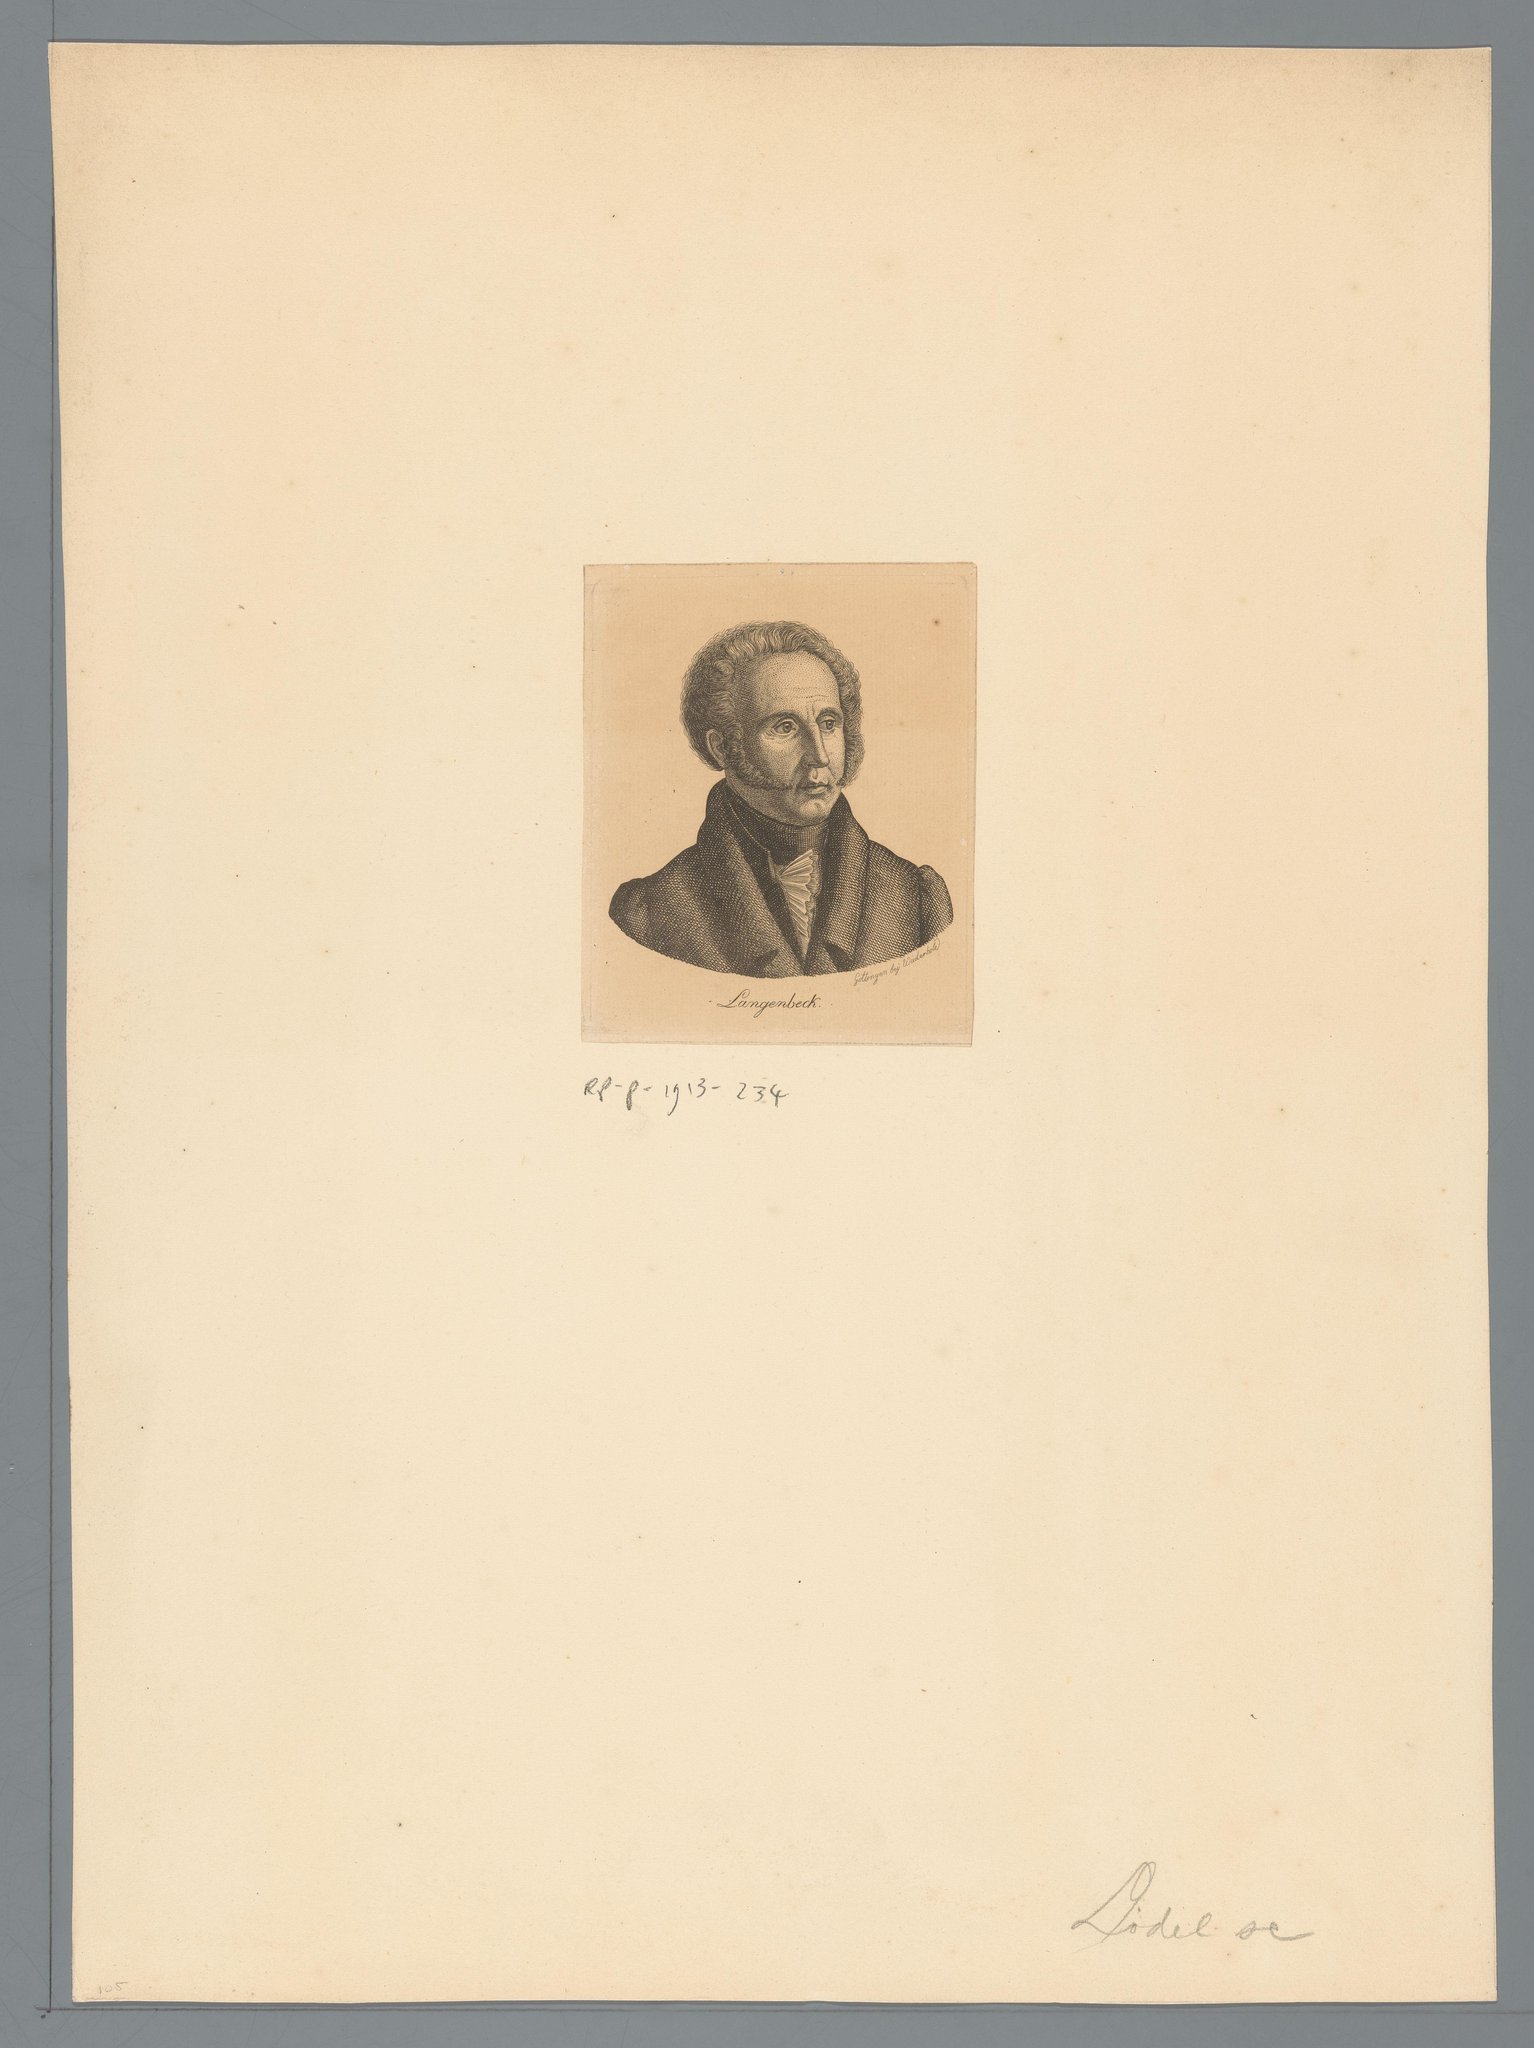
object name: print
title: Portret van Konrad Johann Martin Langenbeck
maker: heinrich lödel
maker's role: print maker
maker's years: 1798-1861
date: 1808-1861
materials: paper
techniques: engraving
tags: historical persons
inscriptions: collector's mark: Lugt 2228